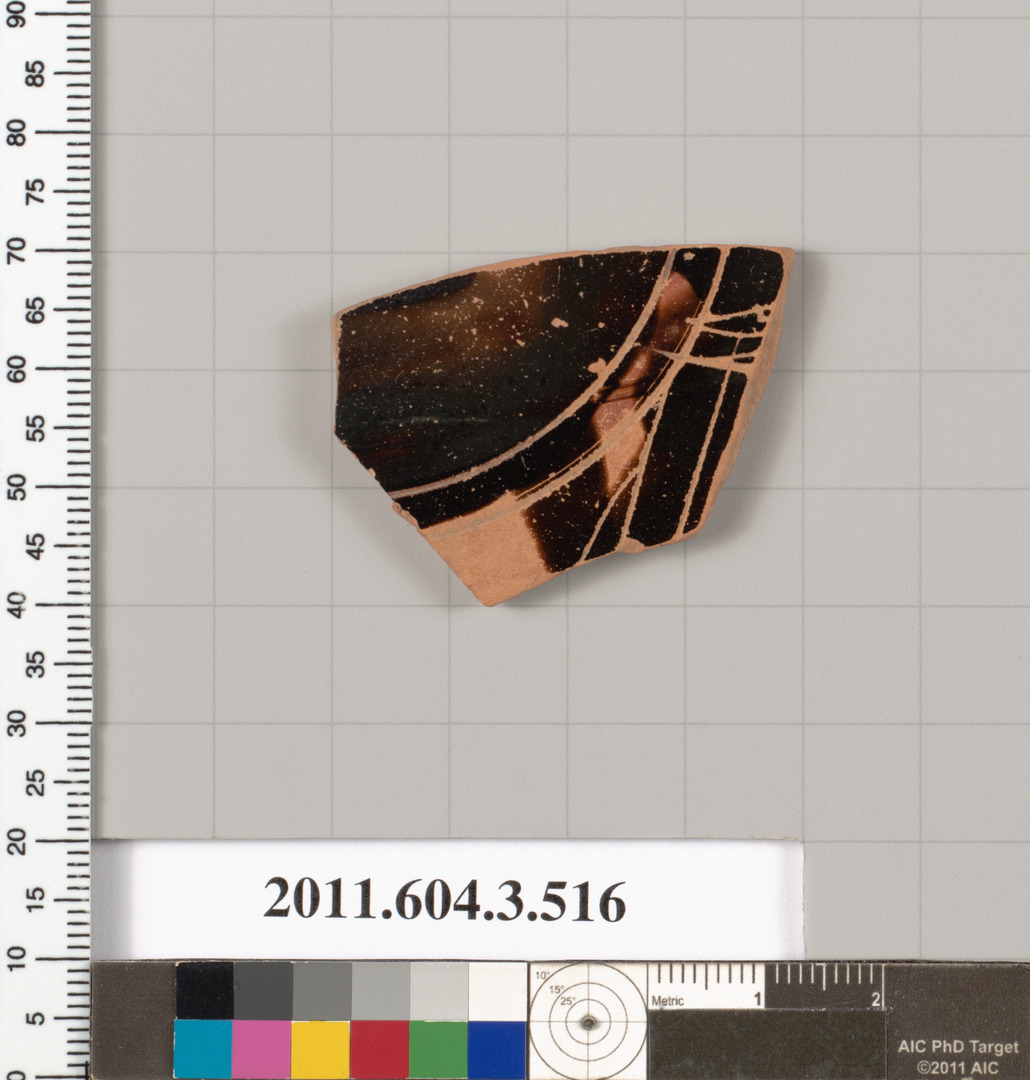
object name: column krater fragment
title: Terracotta fragment of a column-krater (bowl for mixing wine and water)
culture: greek, attic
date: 500-468 BCE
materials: terracotta